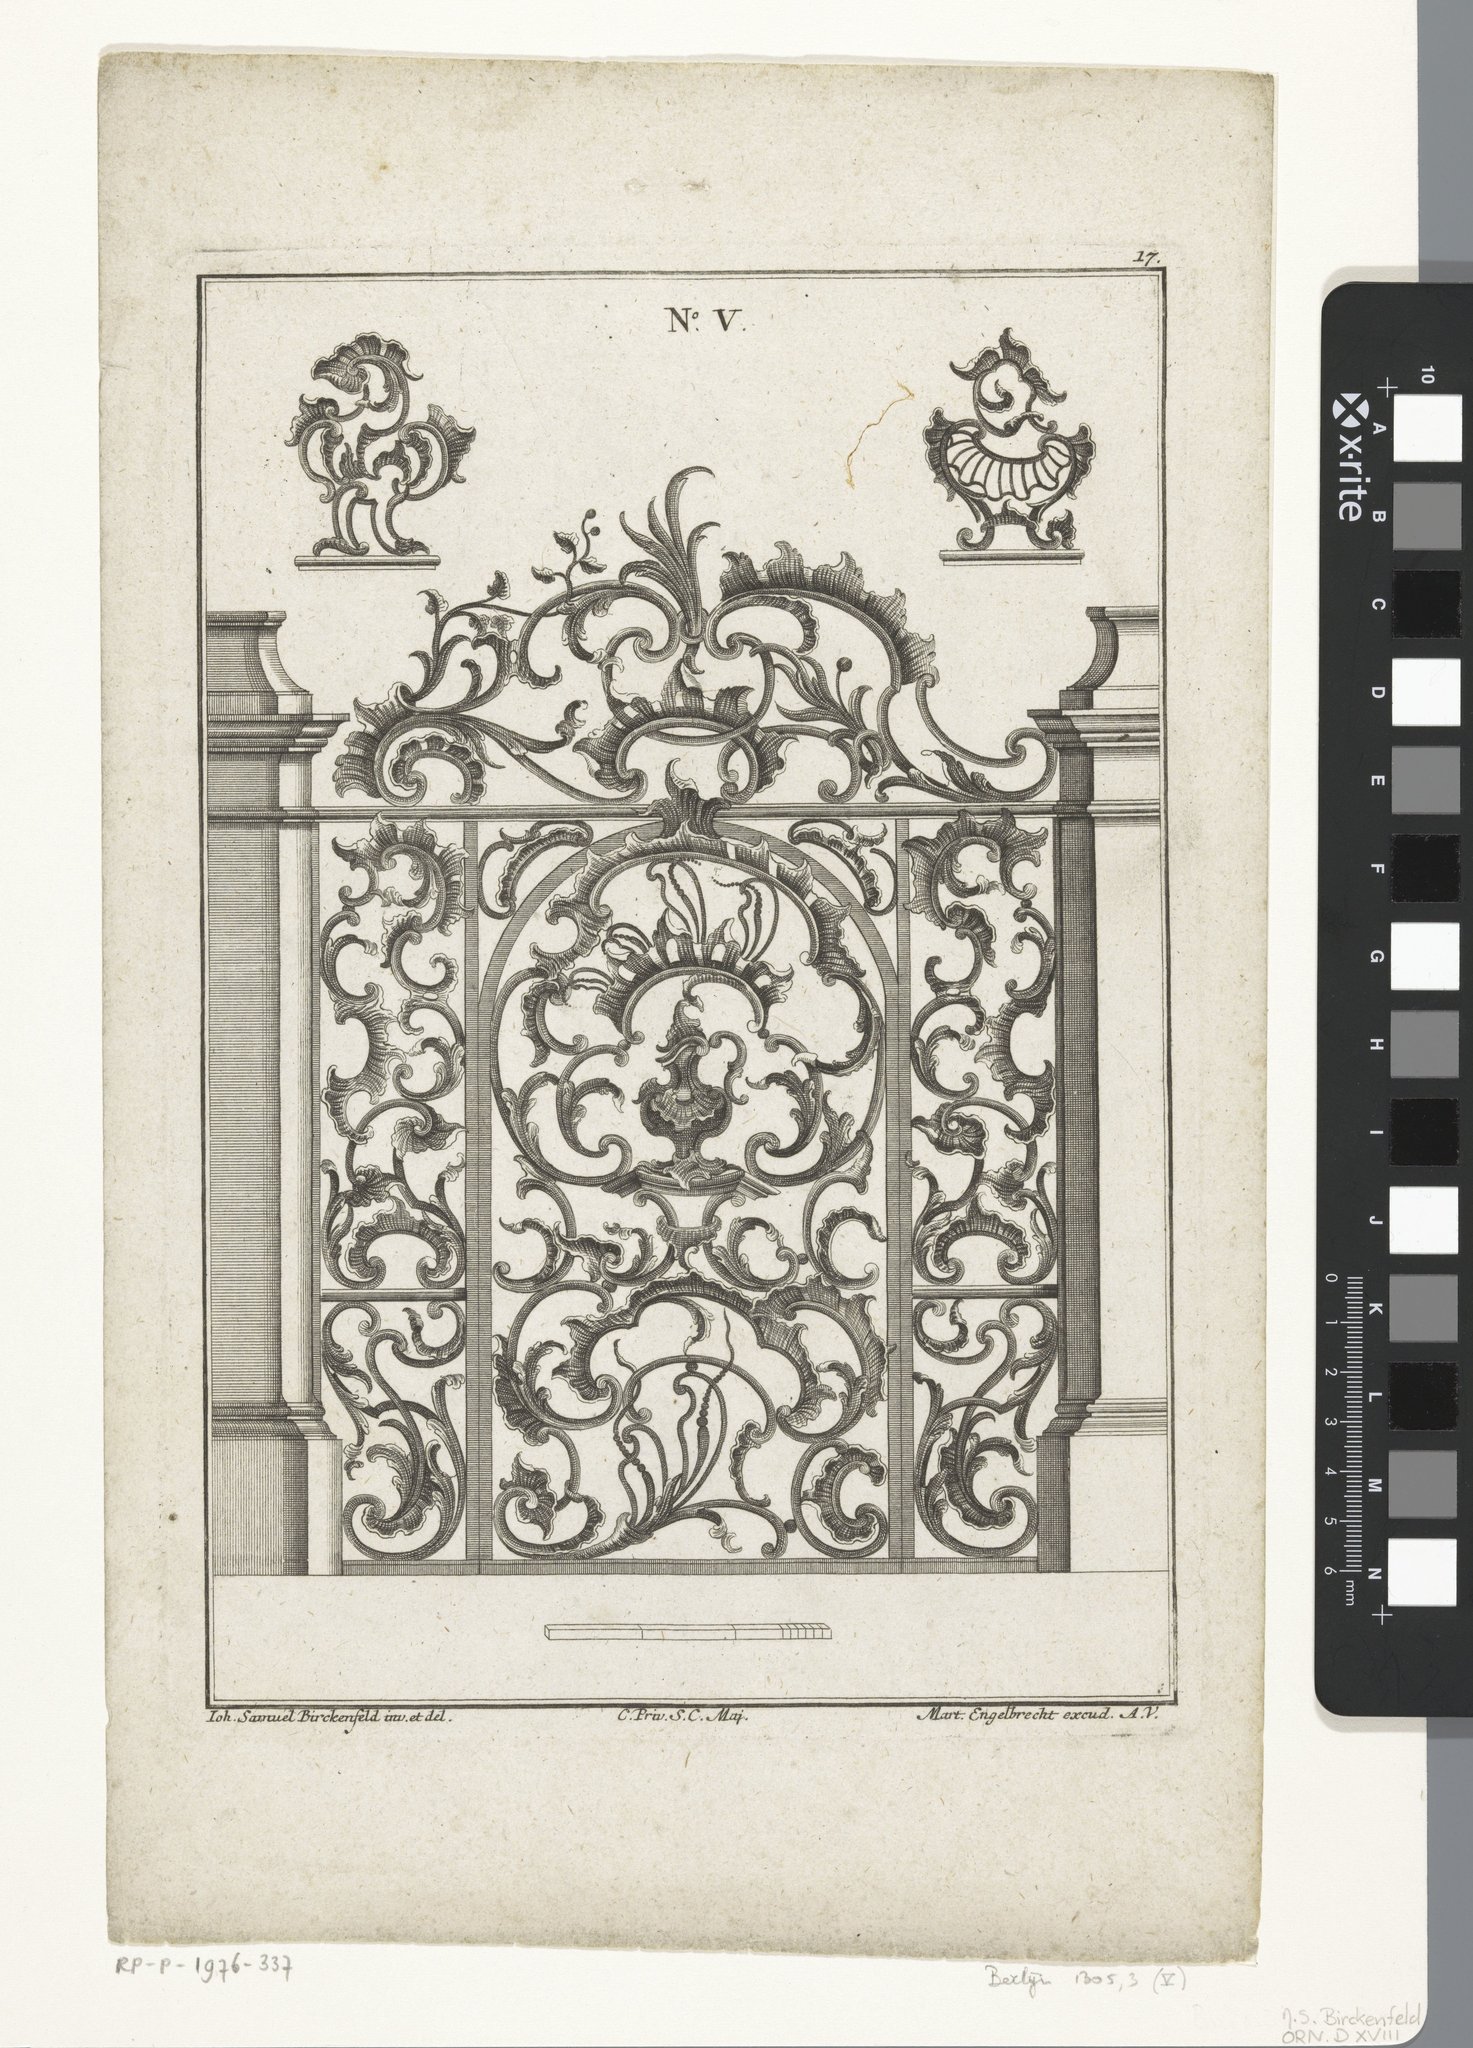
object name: ornament print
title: Ontwerpen voor hekken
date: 1719-1749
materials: paper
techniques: etching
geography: augsburg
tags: floral interlace ~ ornament, gate, entrance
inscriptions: inscription: ‘1e / 27-10-80’, collector's mark: Lugt 2228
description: Midden boven 5 genummerd. De prent hoort bij een serie van vier prenten.